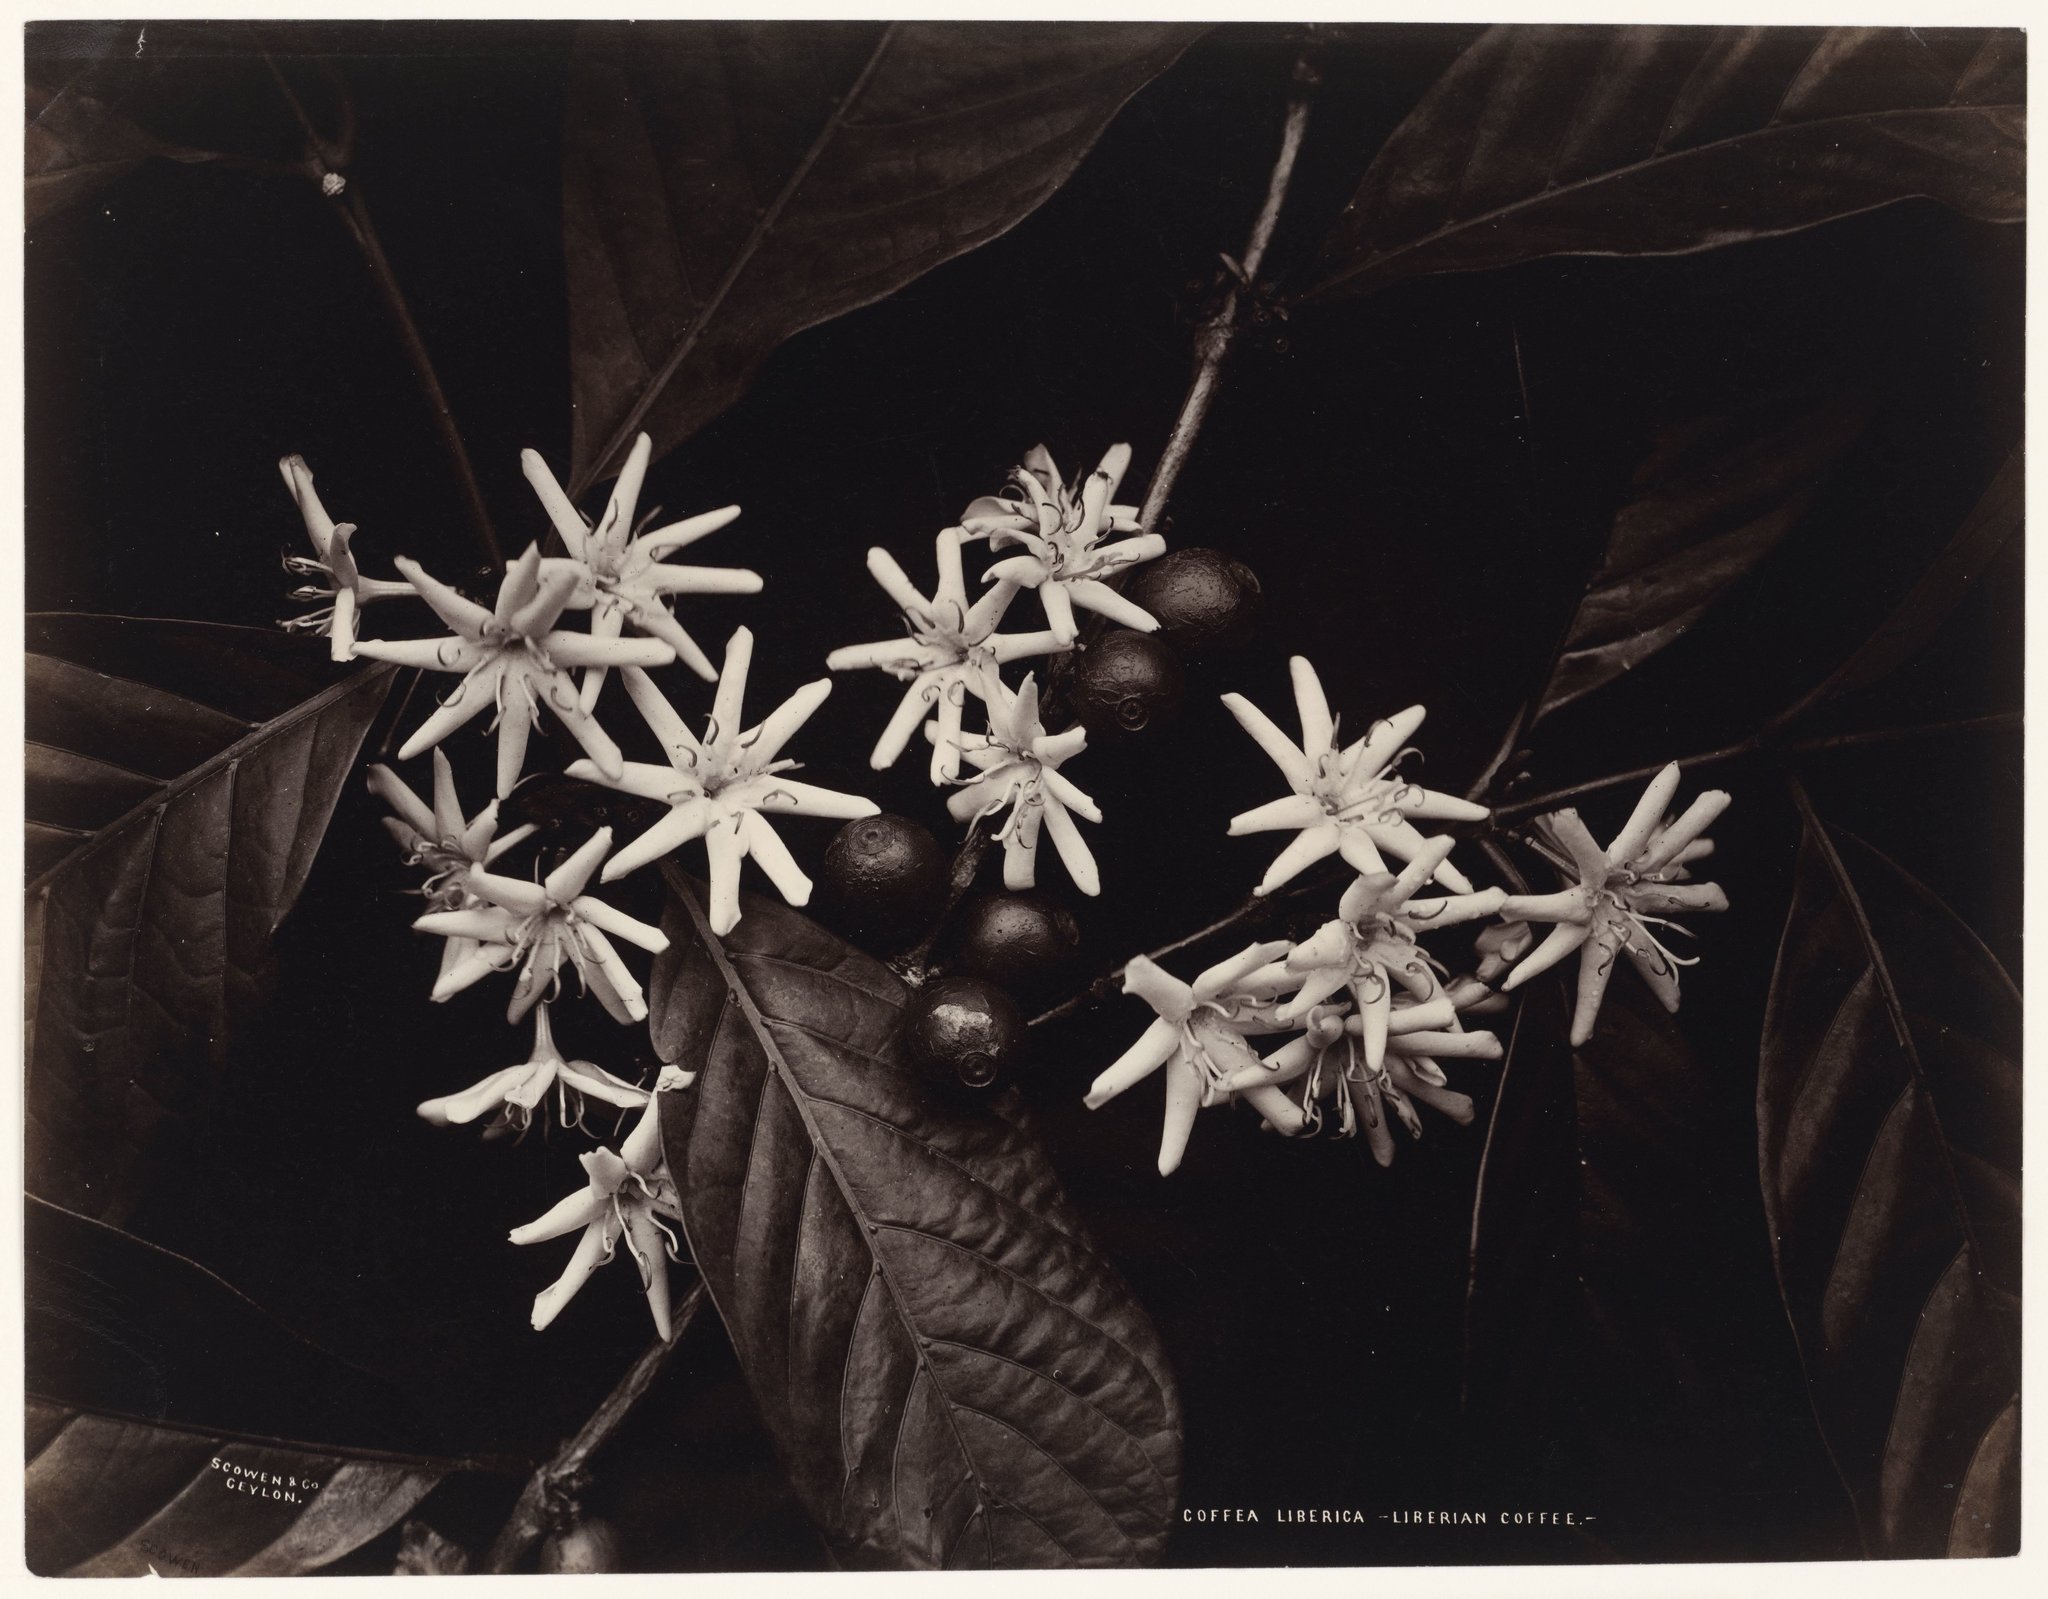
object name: album leaf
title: Blossom of the Liberia Coffee bush, Sri Lanka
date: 1876-1893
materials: paper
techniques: albumen print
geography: sri lanka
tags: flowers, coffee, sri lanka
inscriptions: signature: ‘Scowen & Co./ Ceylon.’, title: ‘Coffea Liberica - Liberian Coffee. -’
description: Deze foto was oorspronkelijk een onderdeel van een fotoalbum met 50 foto's van een reis door Zuidoost-Azië (RP-F-F01197).